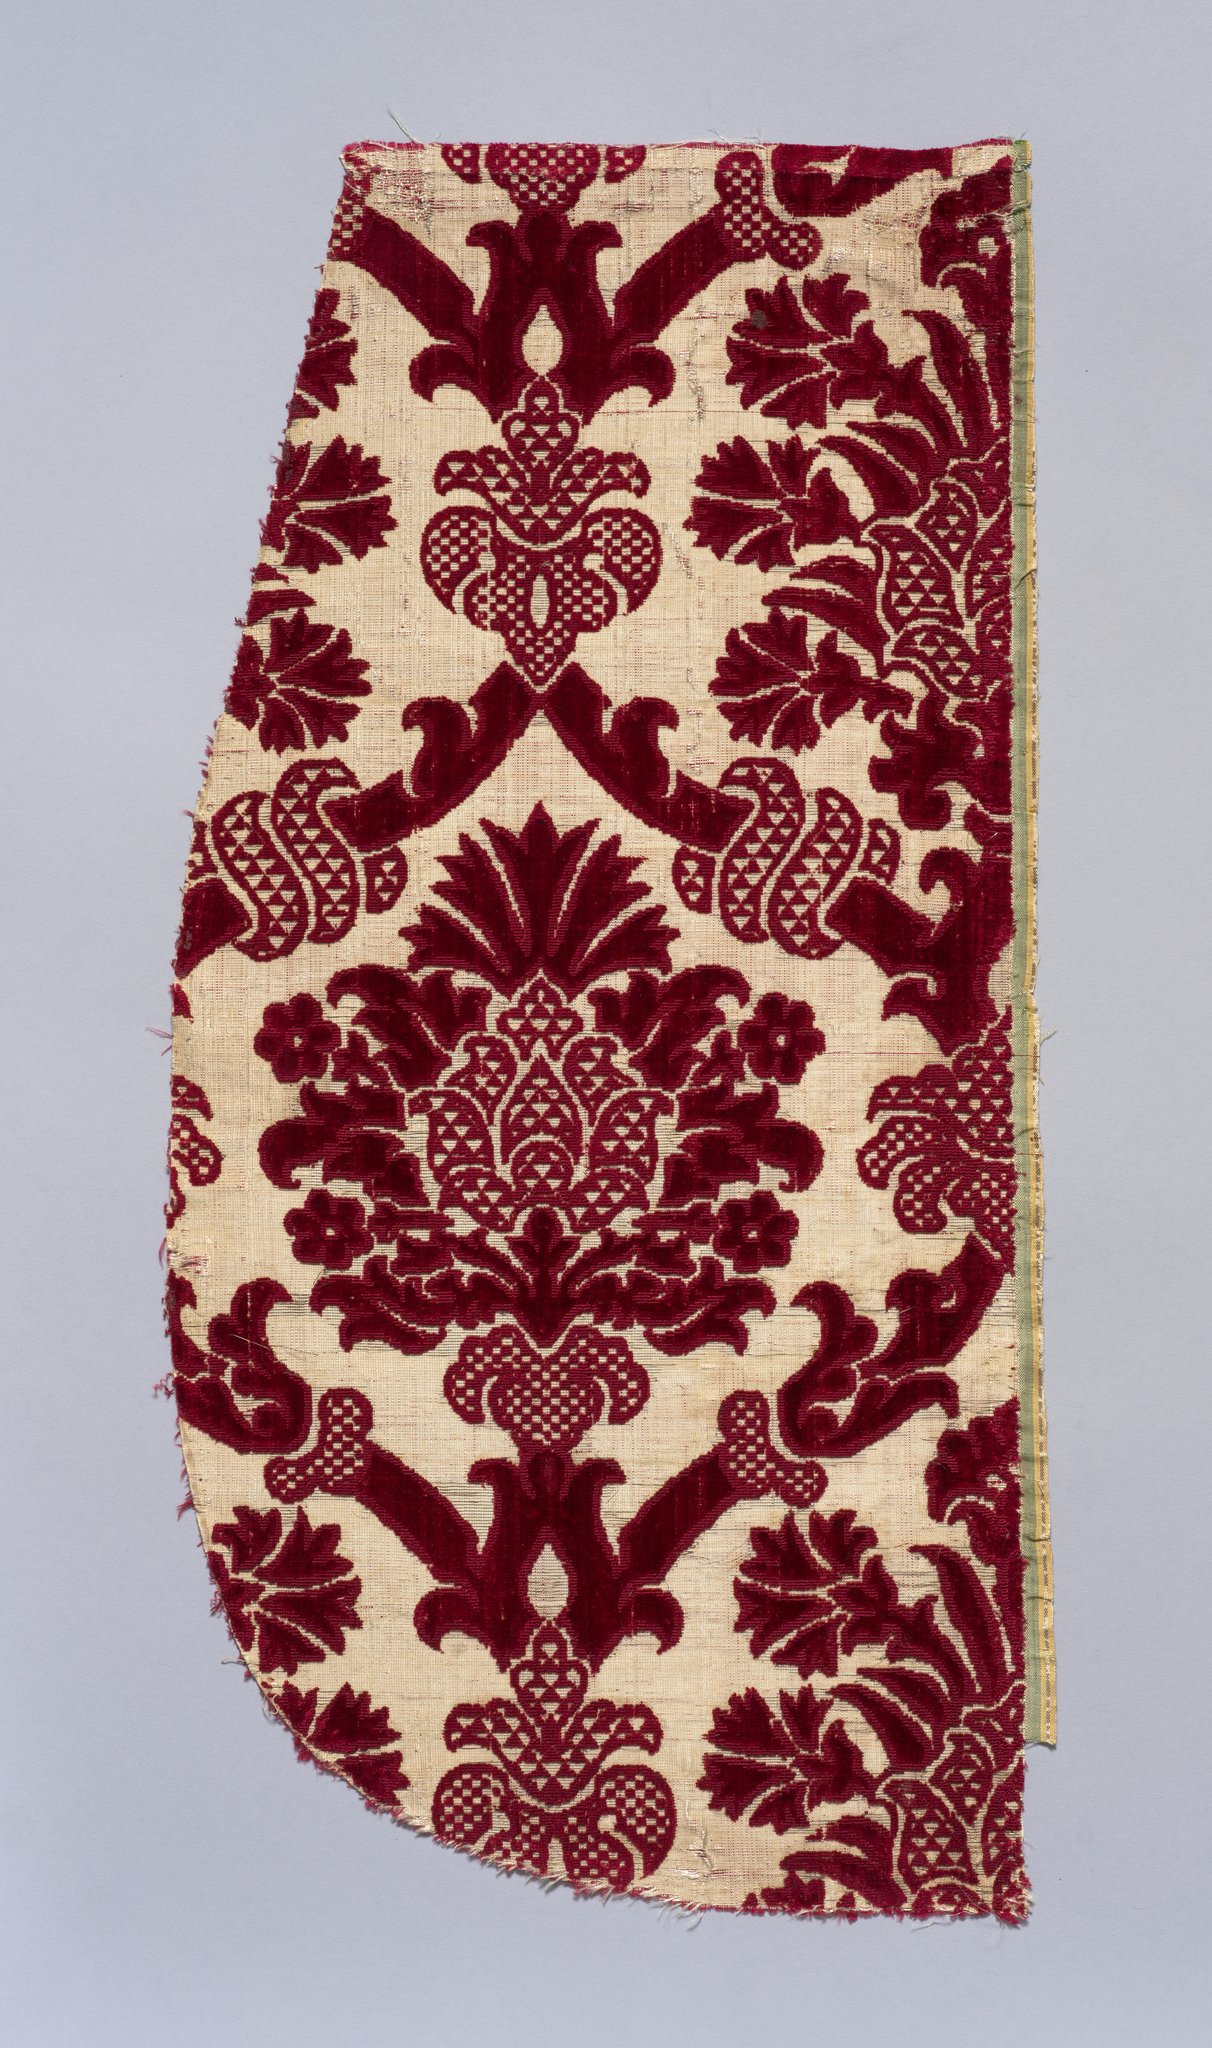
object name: piece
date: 1534-1666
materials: metal thread, silk, velvet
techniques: cutting, voiding